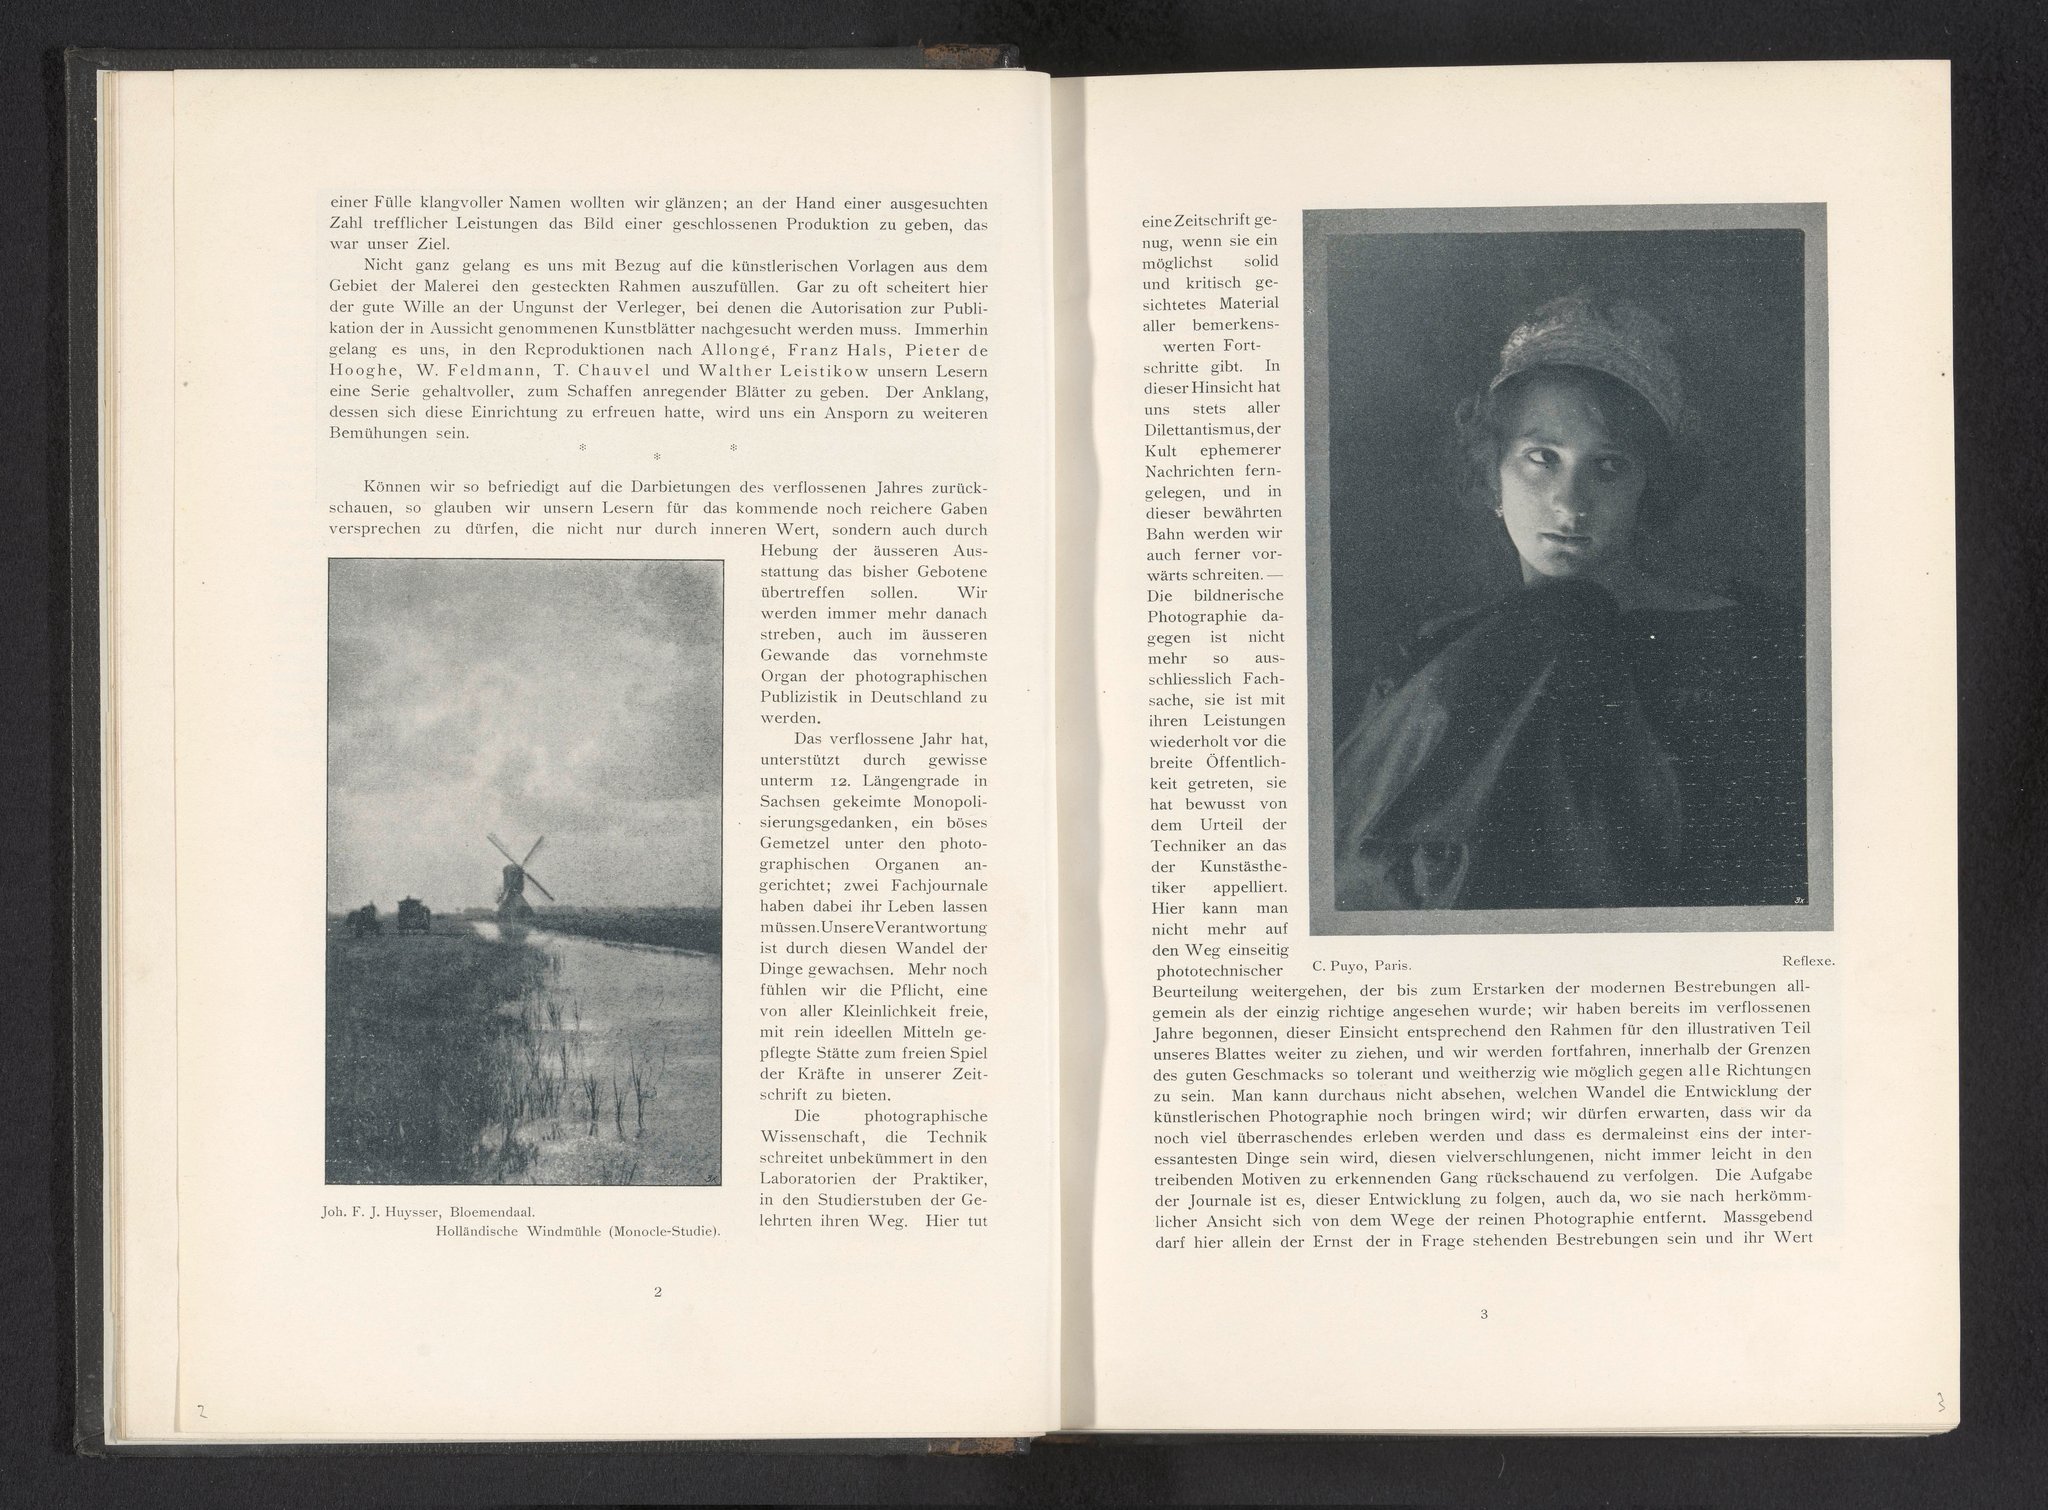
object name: page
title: Bloemendaal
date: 1898-1903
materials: paper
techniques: autotype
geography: bloemendaal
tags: windmill in landscape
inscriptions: inscription: ‘Holländische Windmüle (Monocle-Studie)’, monogram: ‘BX’